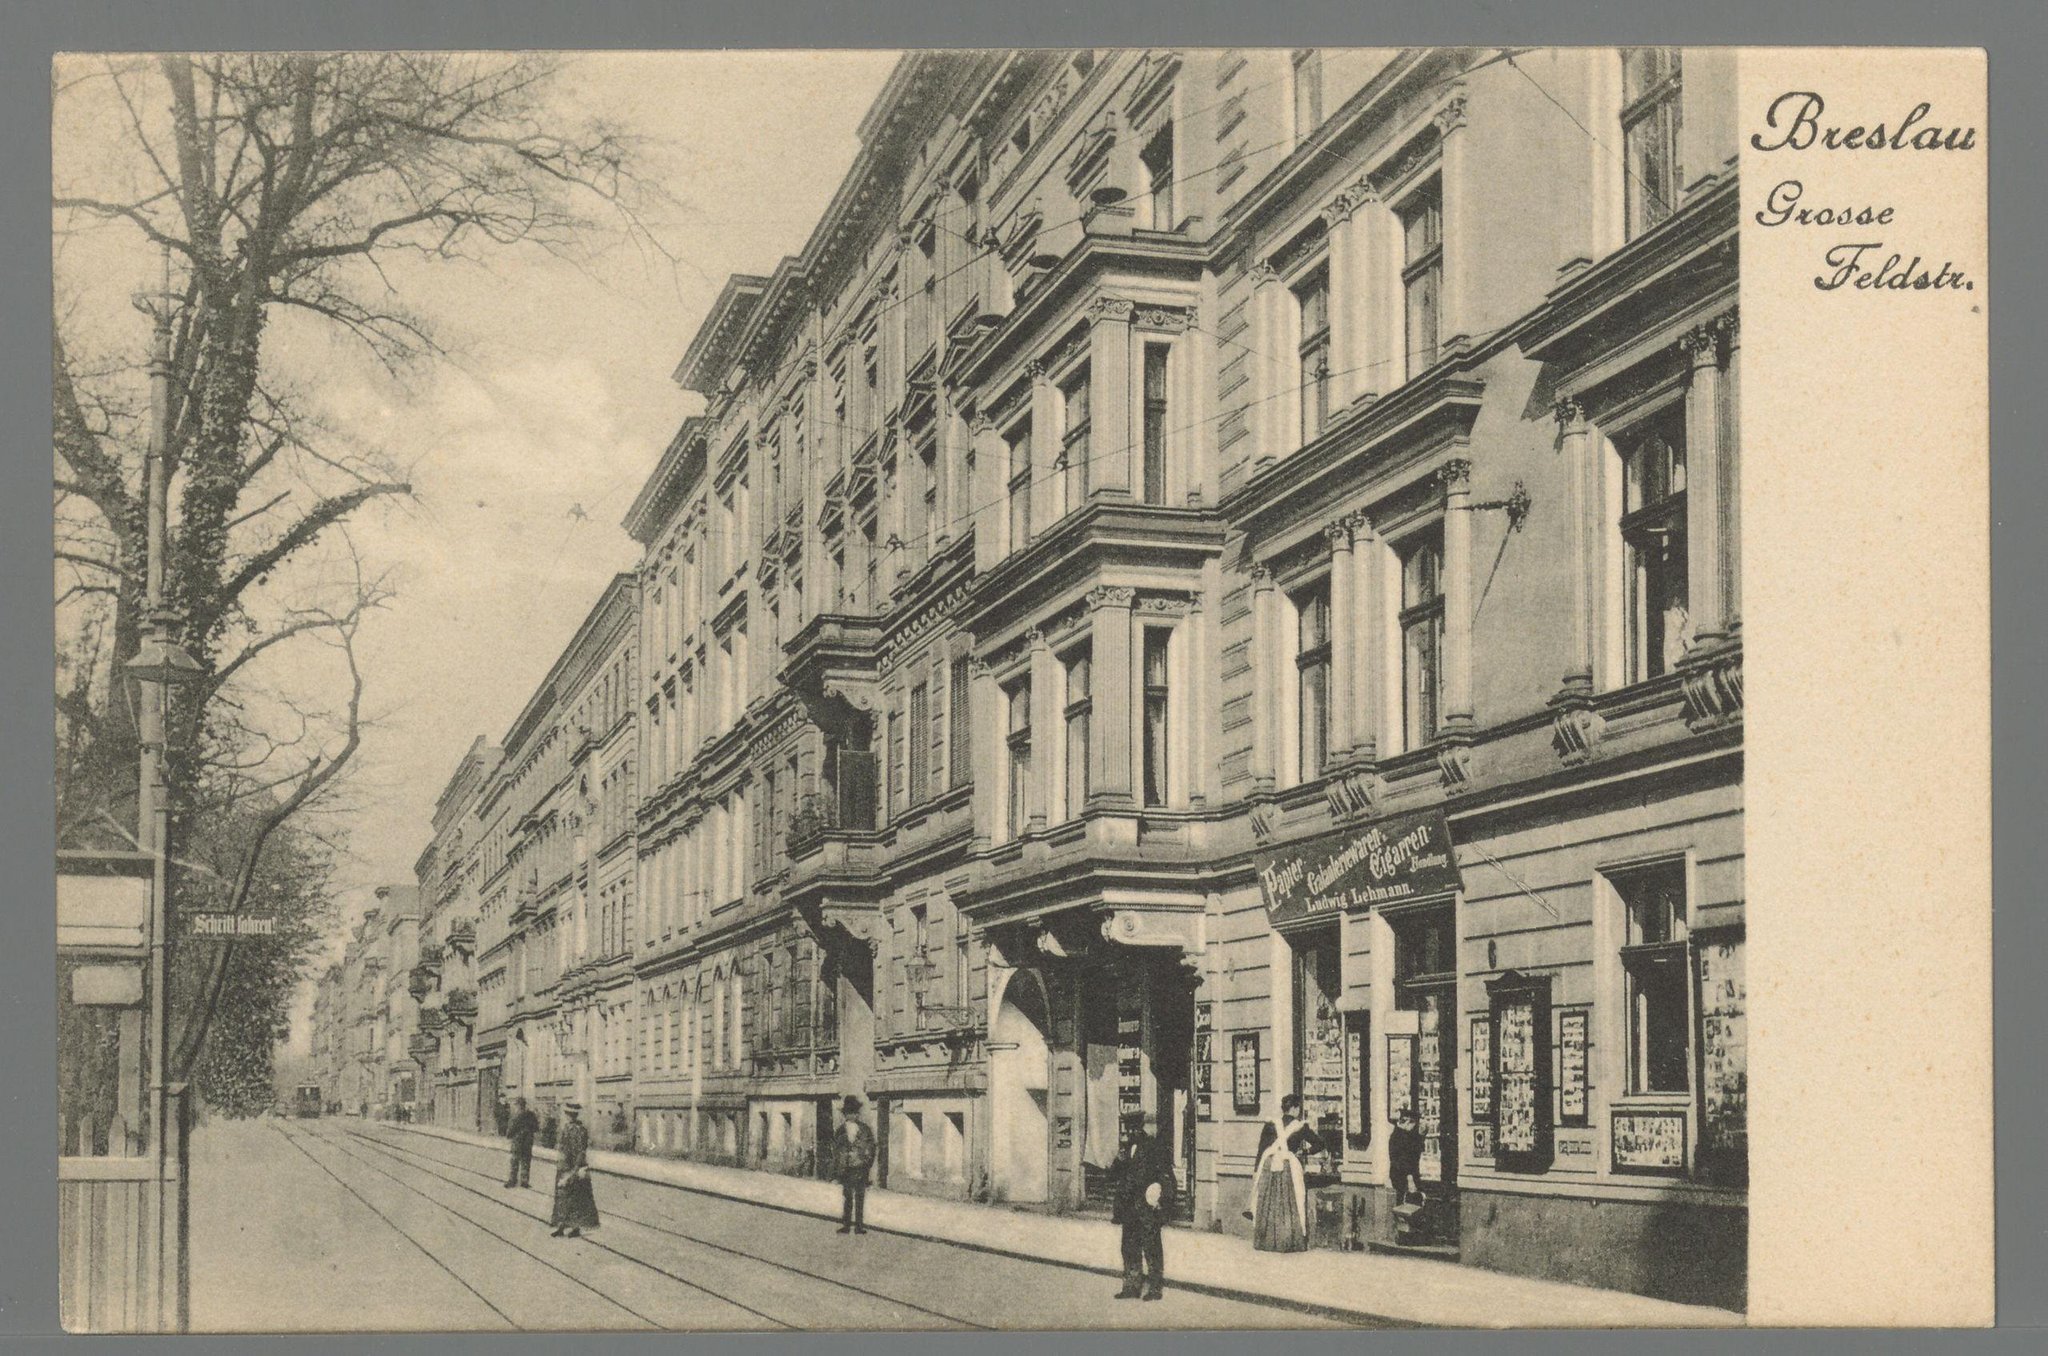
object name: photomechanical print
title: Breslau. Grosse Feldstr.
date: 1905-1930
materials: cardboard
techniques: photograph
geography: breslau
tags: street